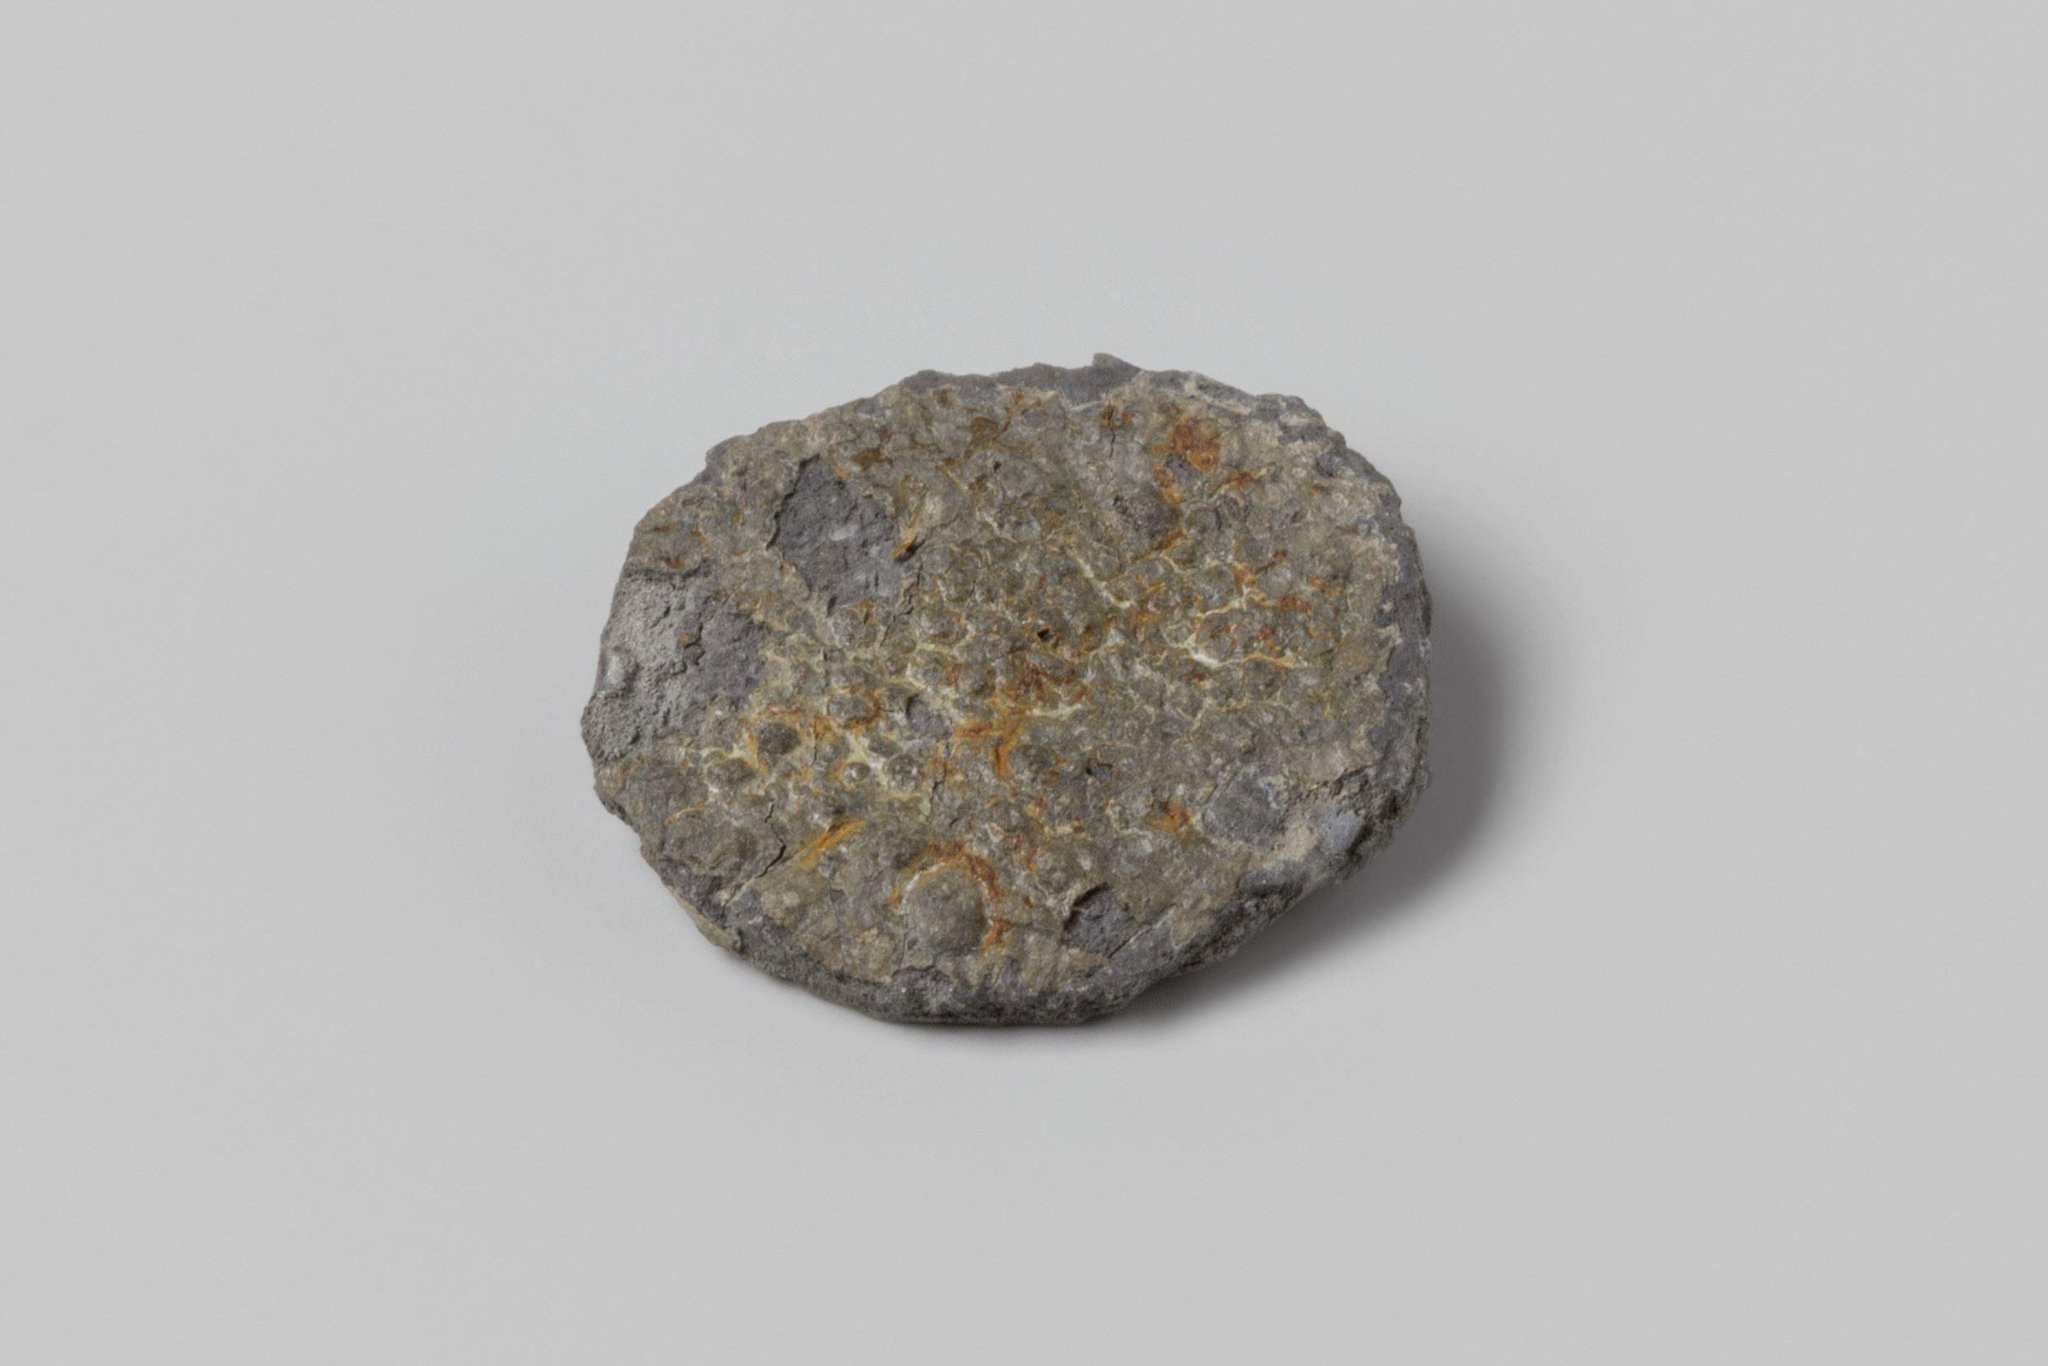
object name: button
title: Knoop uit het wrak van de Oost-Indiëvaarder Hollandia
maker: Anonymous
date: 1700-1743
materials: tin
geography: netherlands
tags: verenigde oostindische compagnie, hollandia (schip), annet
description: Knoop. (1) flat, bevelled rim, relieved decoration of fabric motif (1.7d, 0.3t), loop-shank